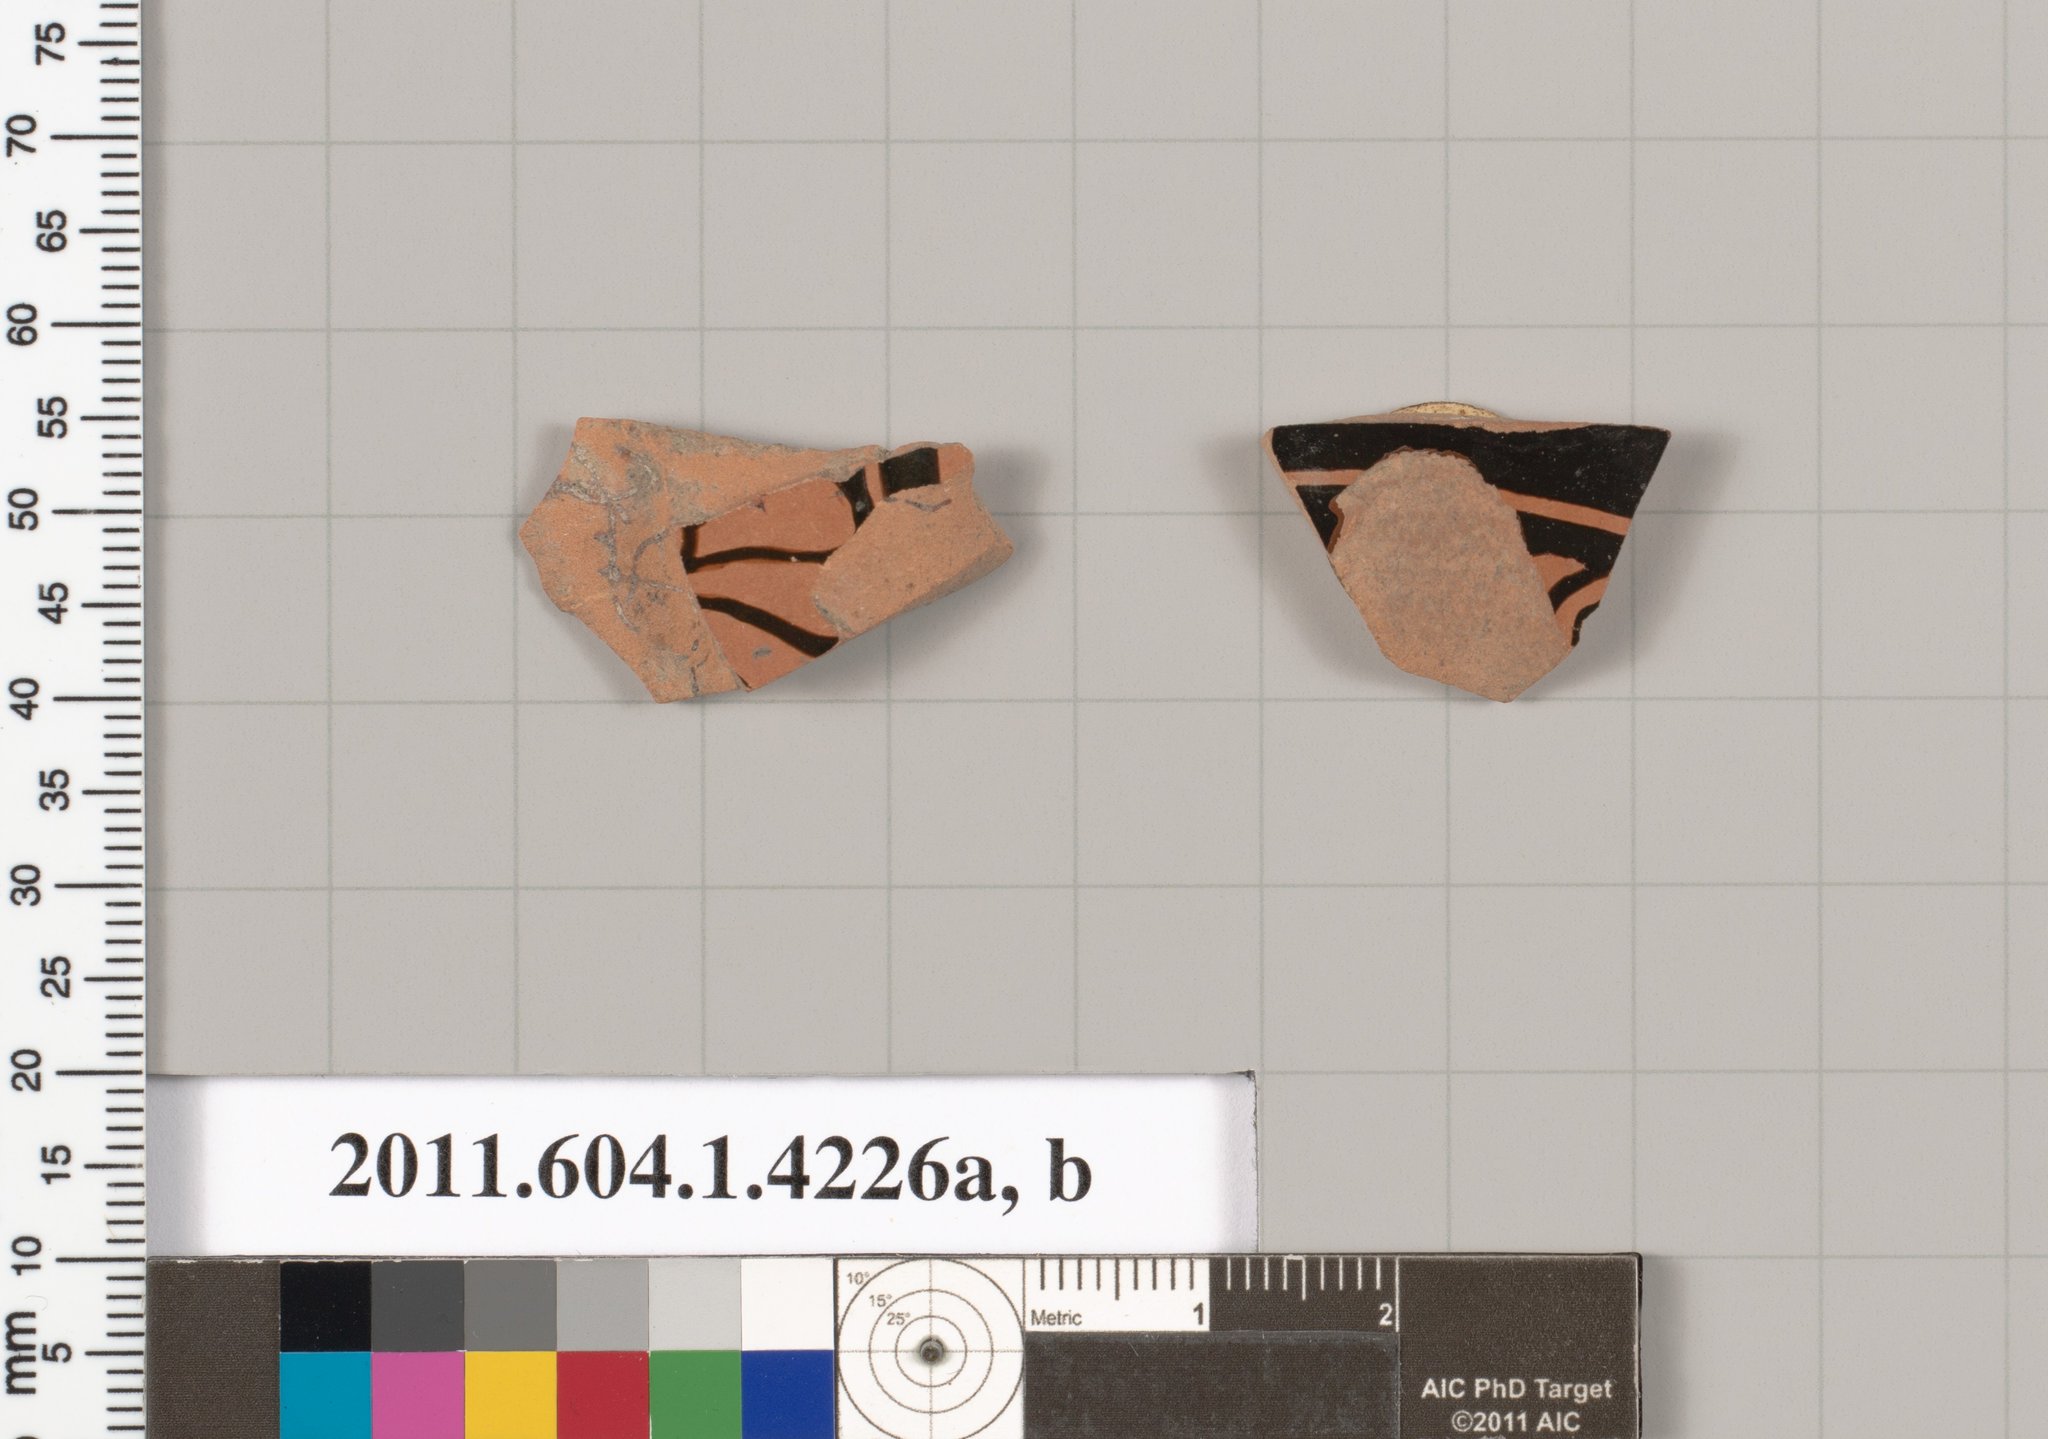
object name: kylix fragment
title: Terracotta fragments of kylikes (drinking cups)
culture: greek, attic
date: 500-451 BCE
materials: terracotta